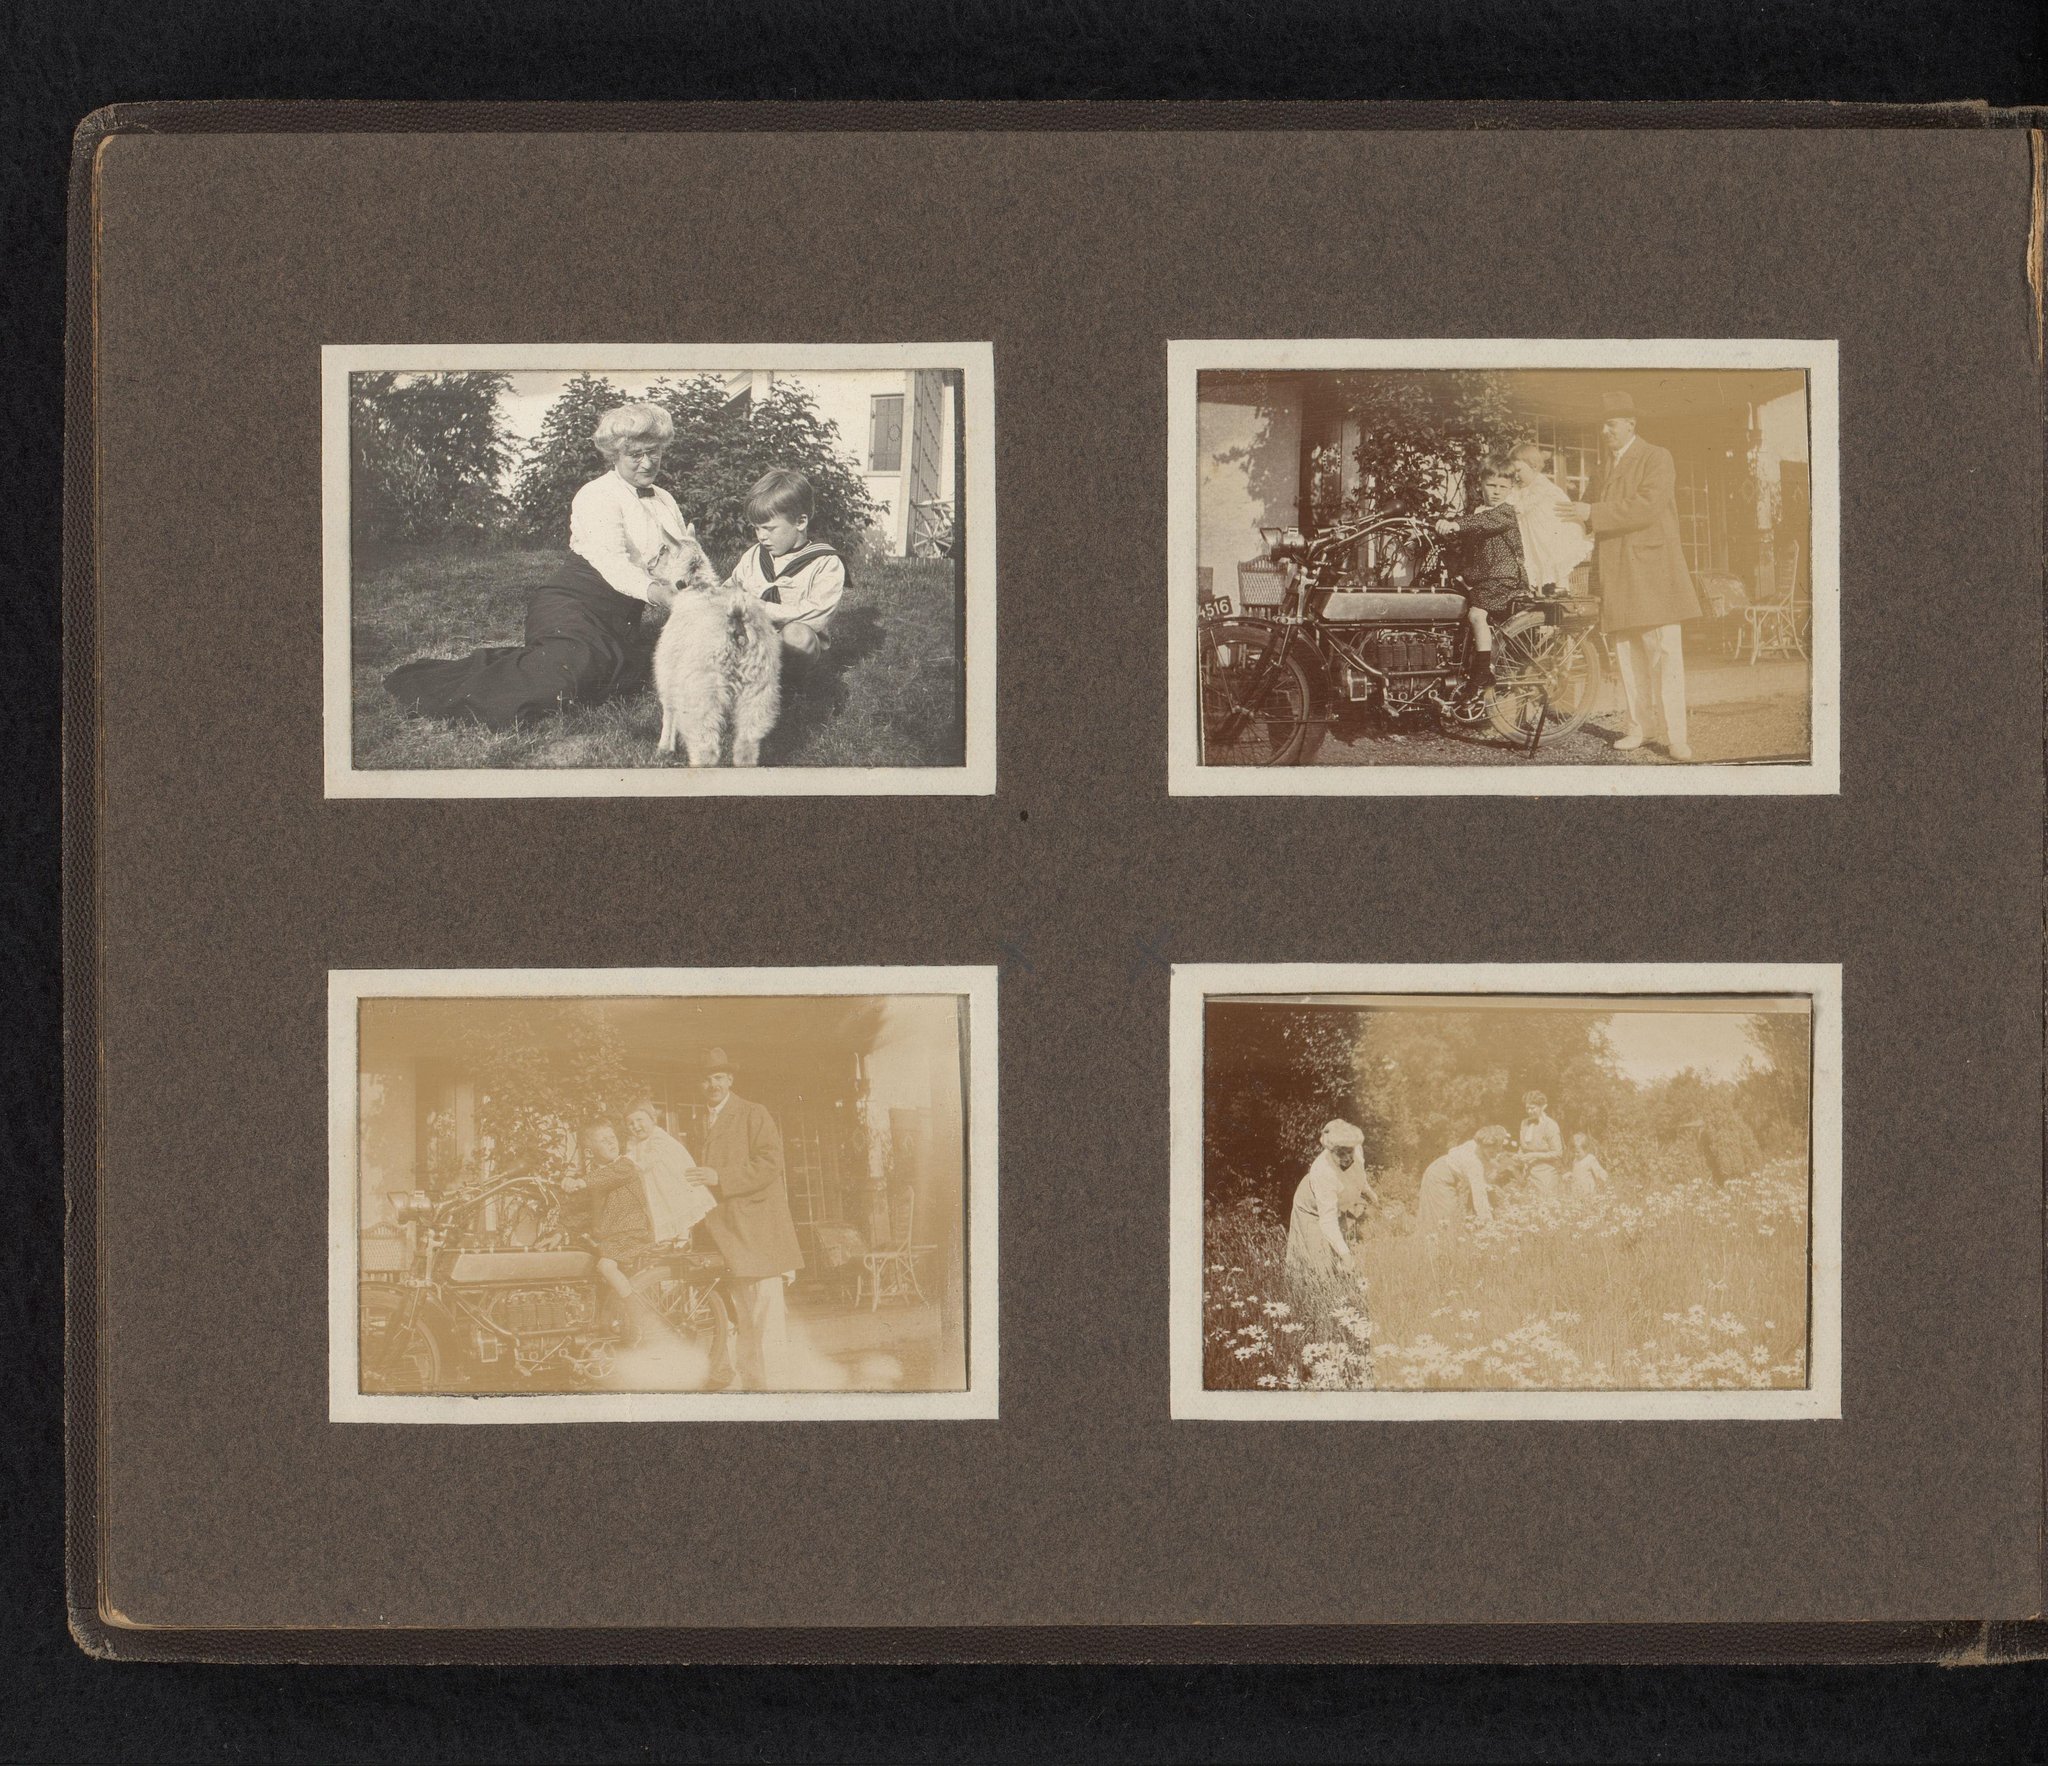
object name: album leaf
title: Vier foto's van de familie Van den Berg met anderen in Bergerac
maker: hendrik herman van den berg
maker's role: amateurfotograaf, jurist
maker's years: 1875-1944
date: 1914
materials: paper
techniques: gelatin silver print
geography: bergerac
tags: batavia, hendrik herman van den berg, amsterdam, carel frederik van den berg (cay), frank willem van den berg (1912-1998), the family travelling, on holiday, motor-cycles and other two-wheeled motor-vehicles, child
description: Deze foto's maken deel uit van een album.